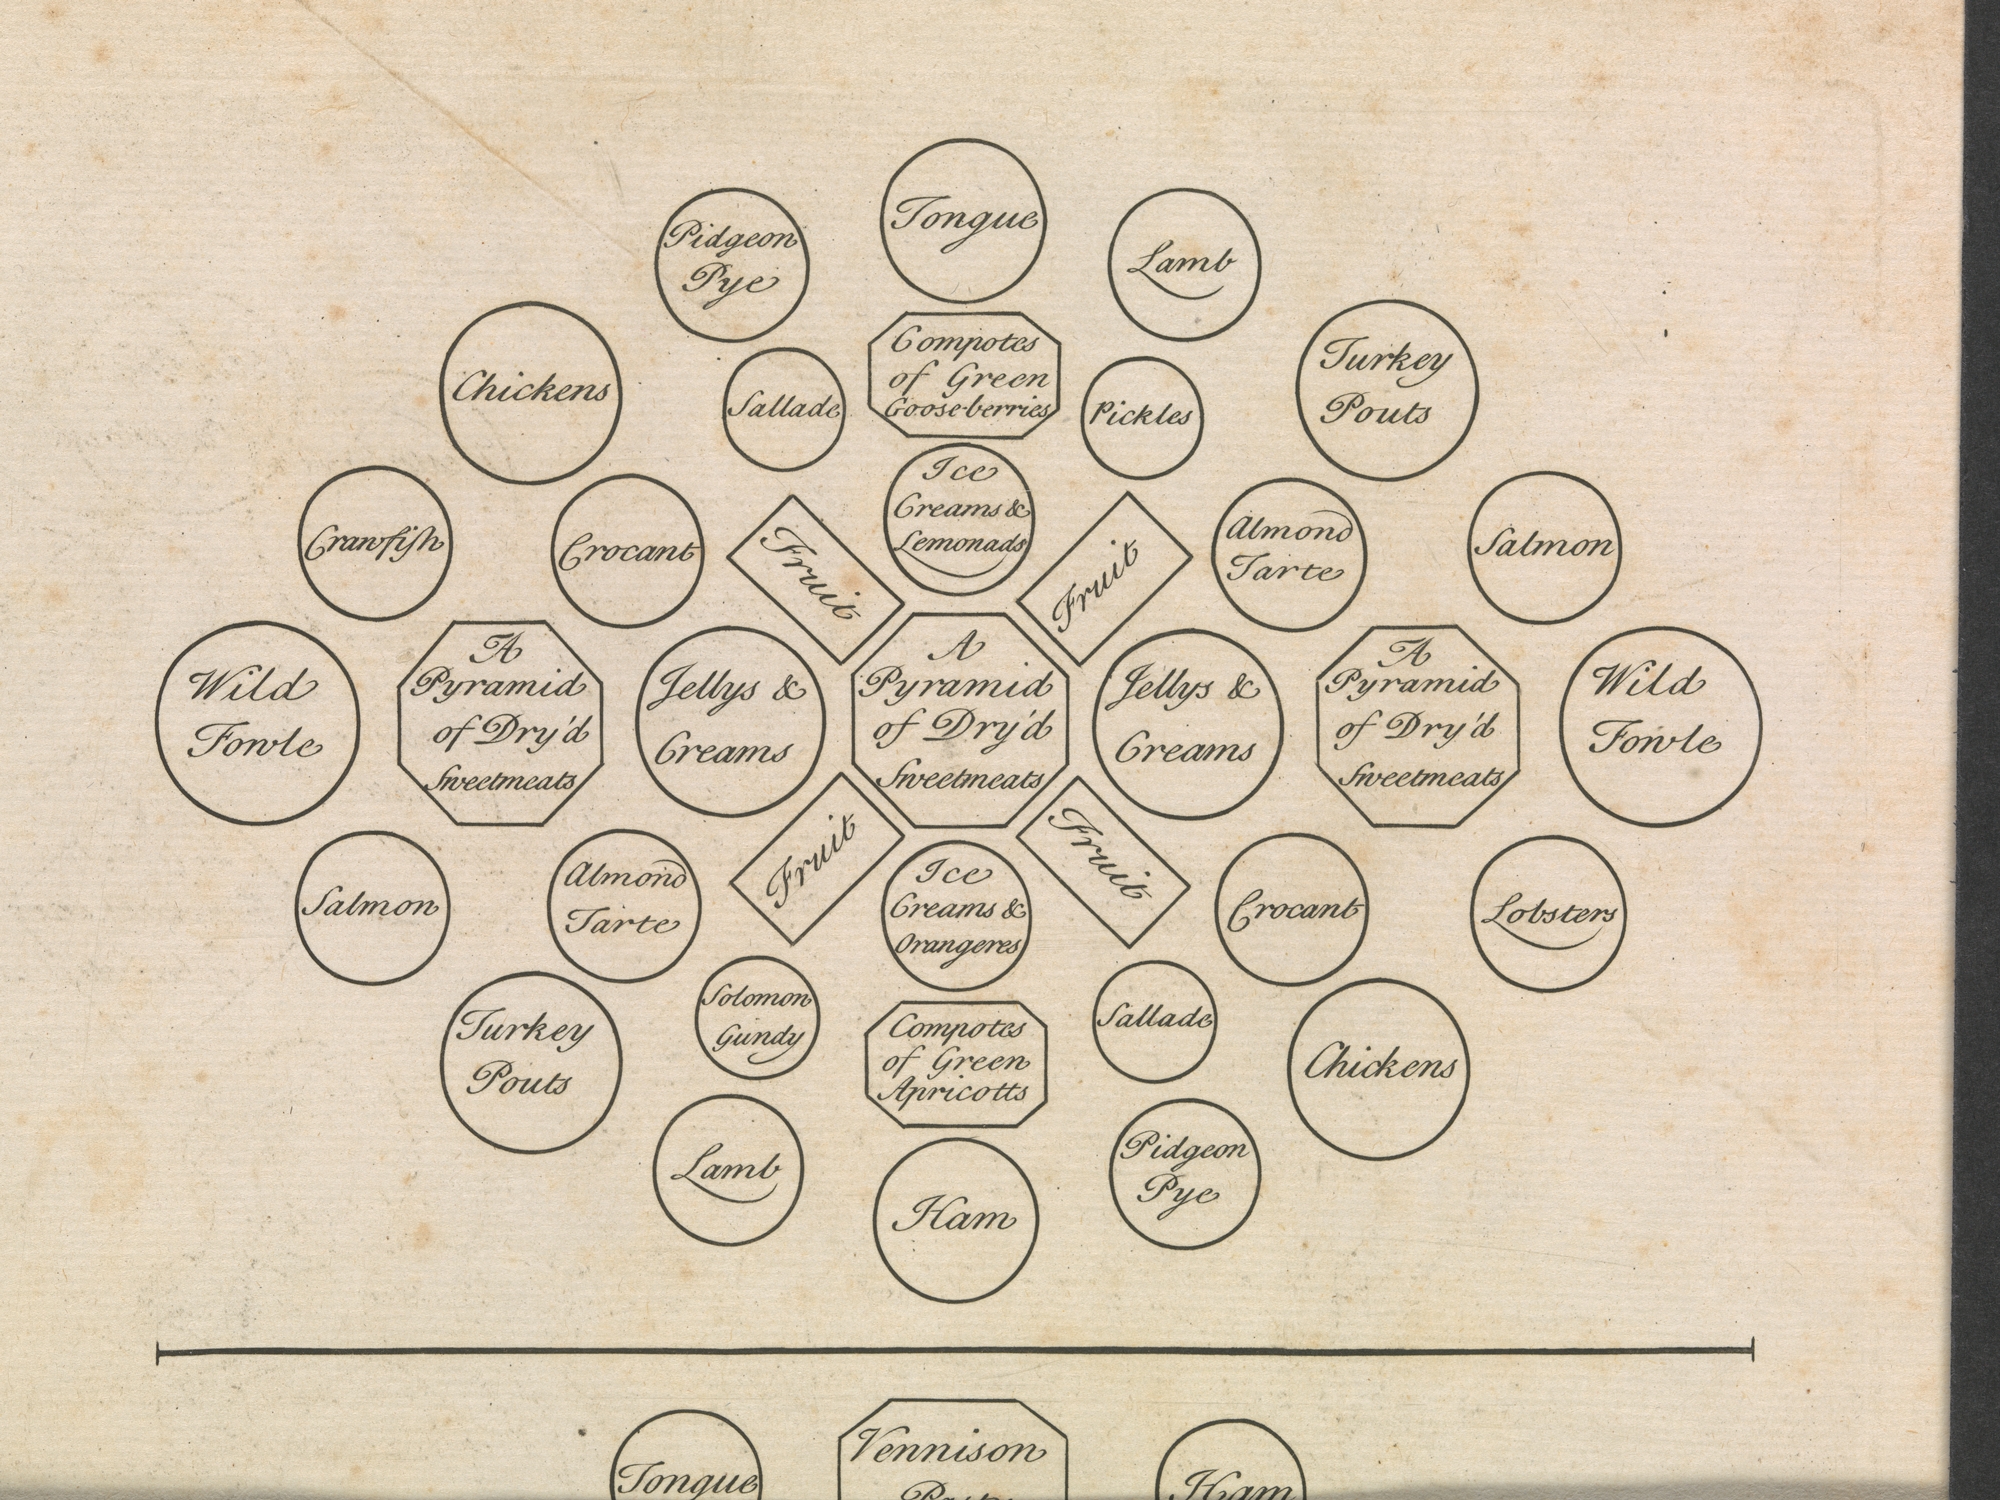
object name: book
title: The procession and Ceremonies...Installation of the Knights Companions of ...Order of the Bath . with Arms, Names, Titles...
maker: john pine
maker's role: author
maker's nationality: british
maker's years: 1690-1756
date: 1730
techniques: engraving, etching